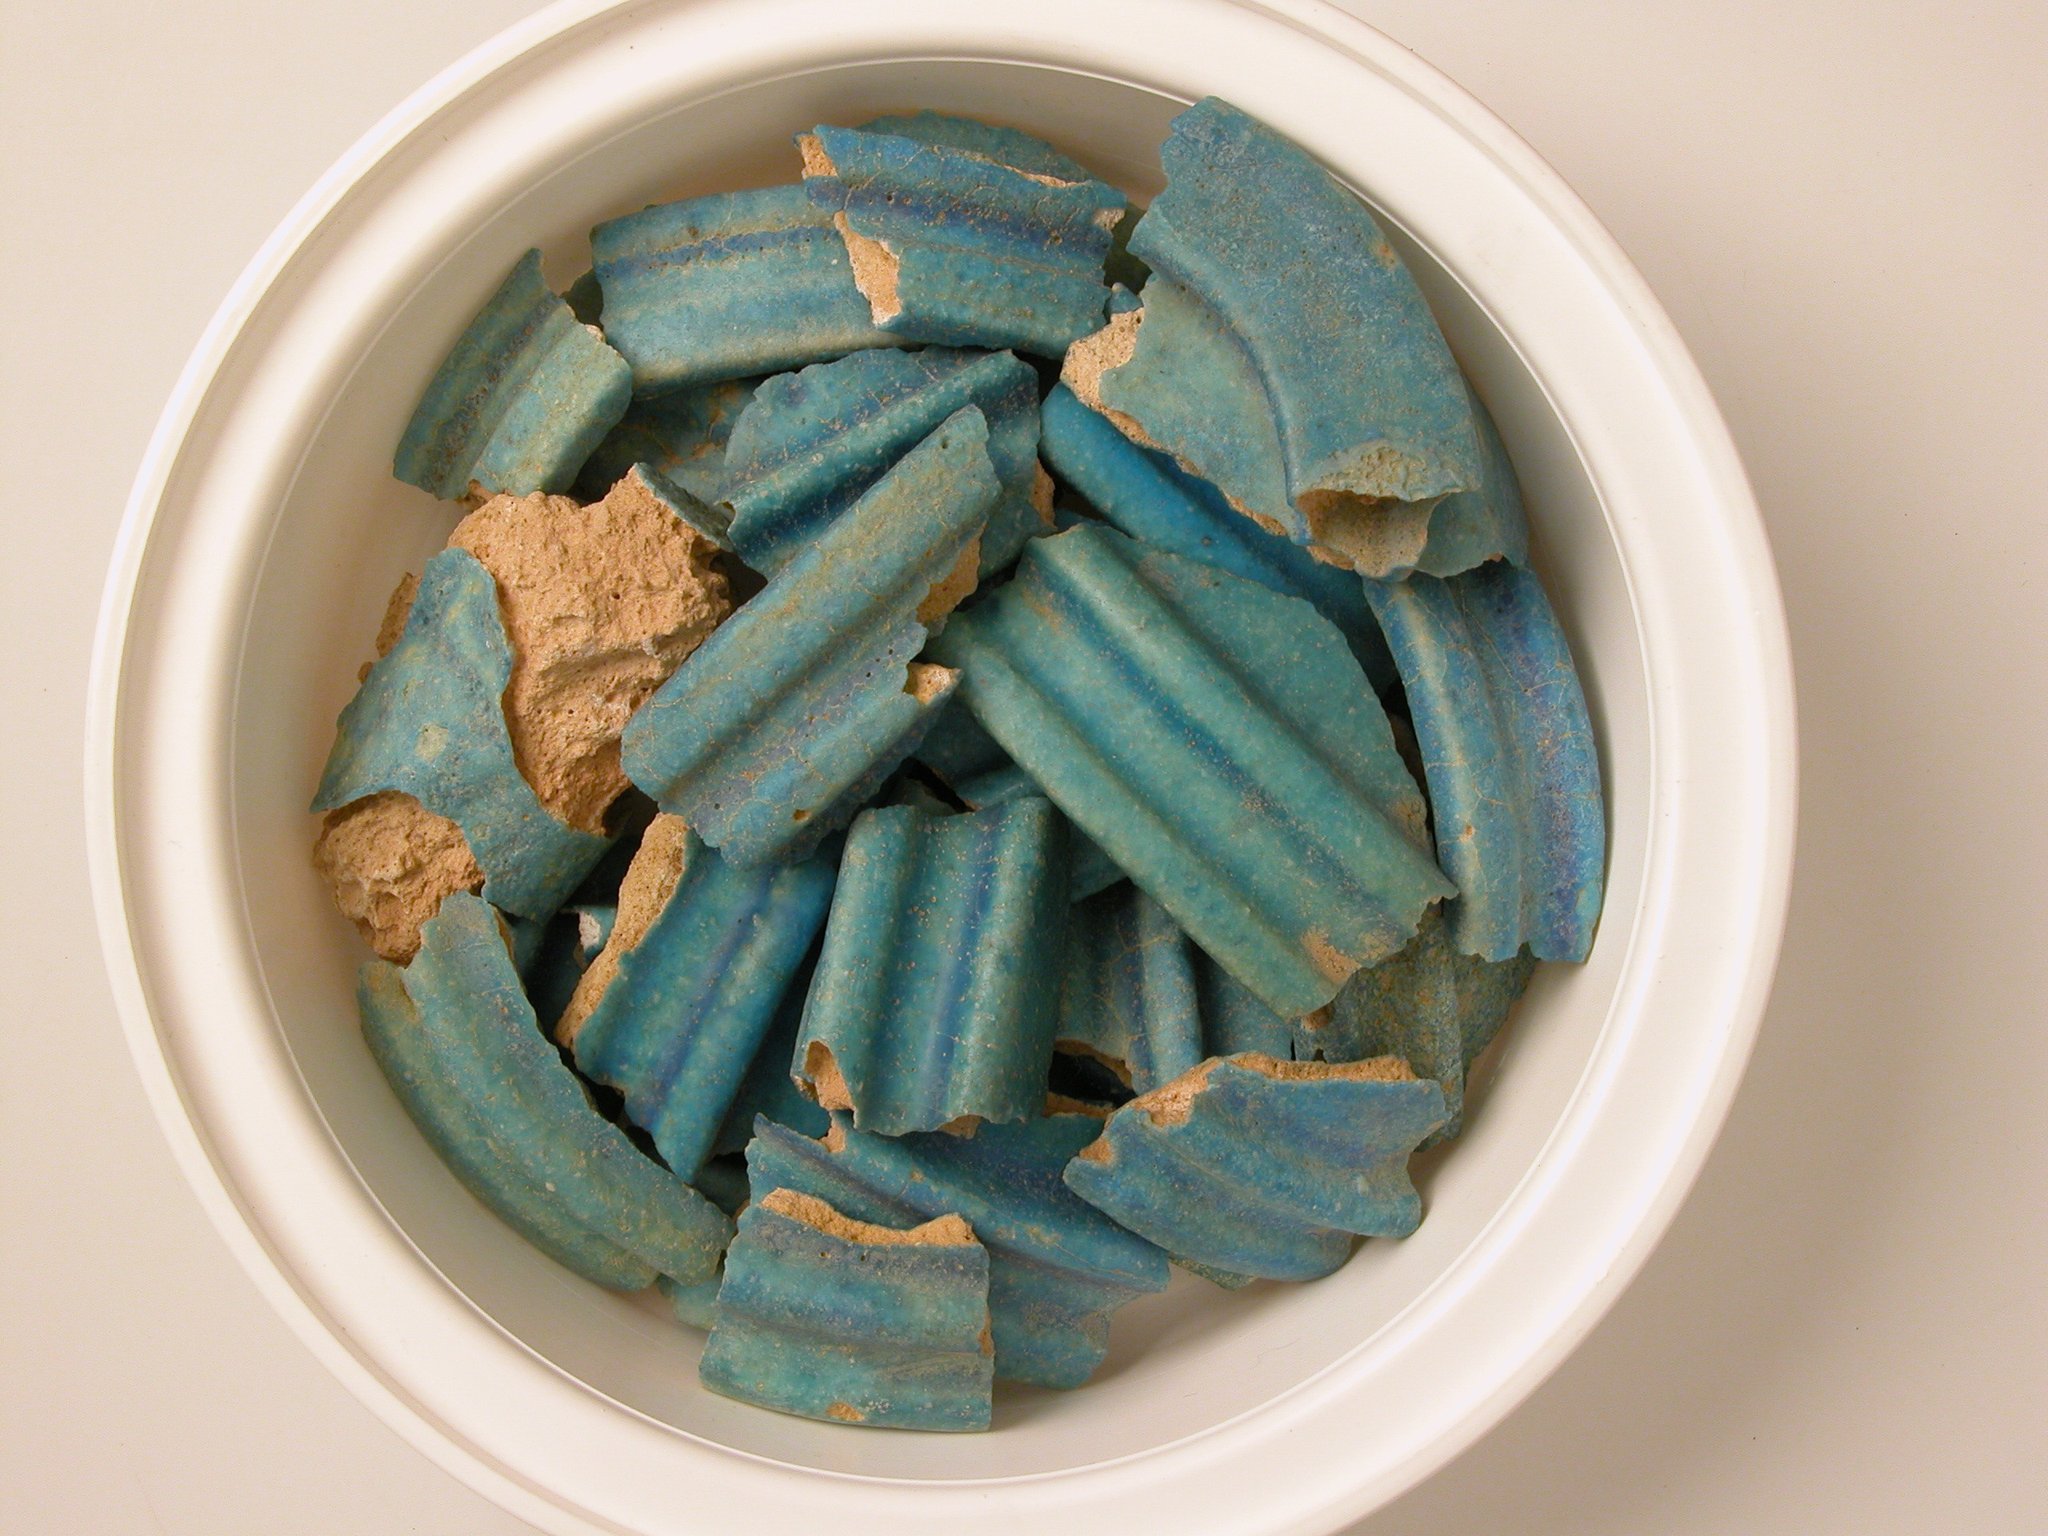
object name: fragment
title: Vessel Fragments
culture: coptic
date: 301-700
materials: earthenware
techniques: glazing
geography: egypt